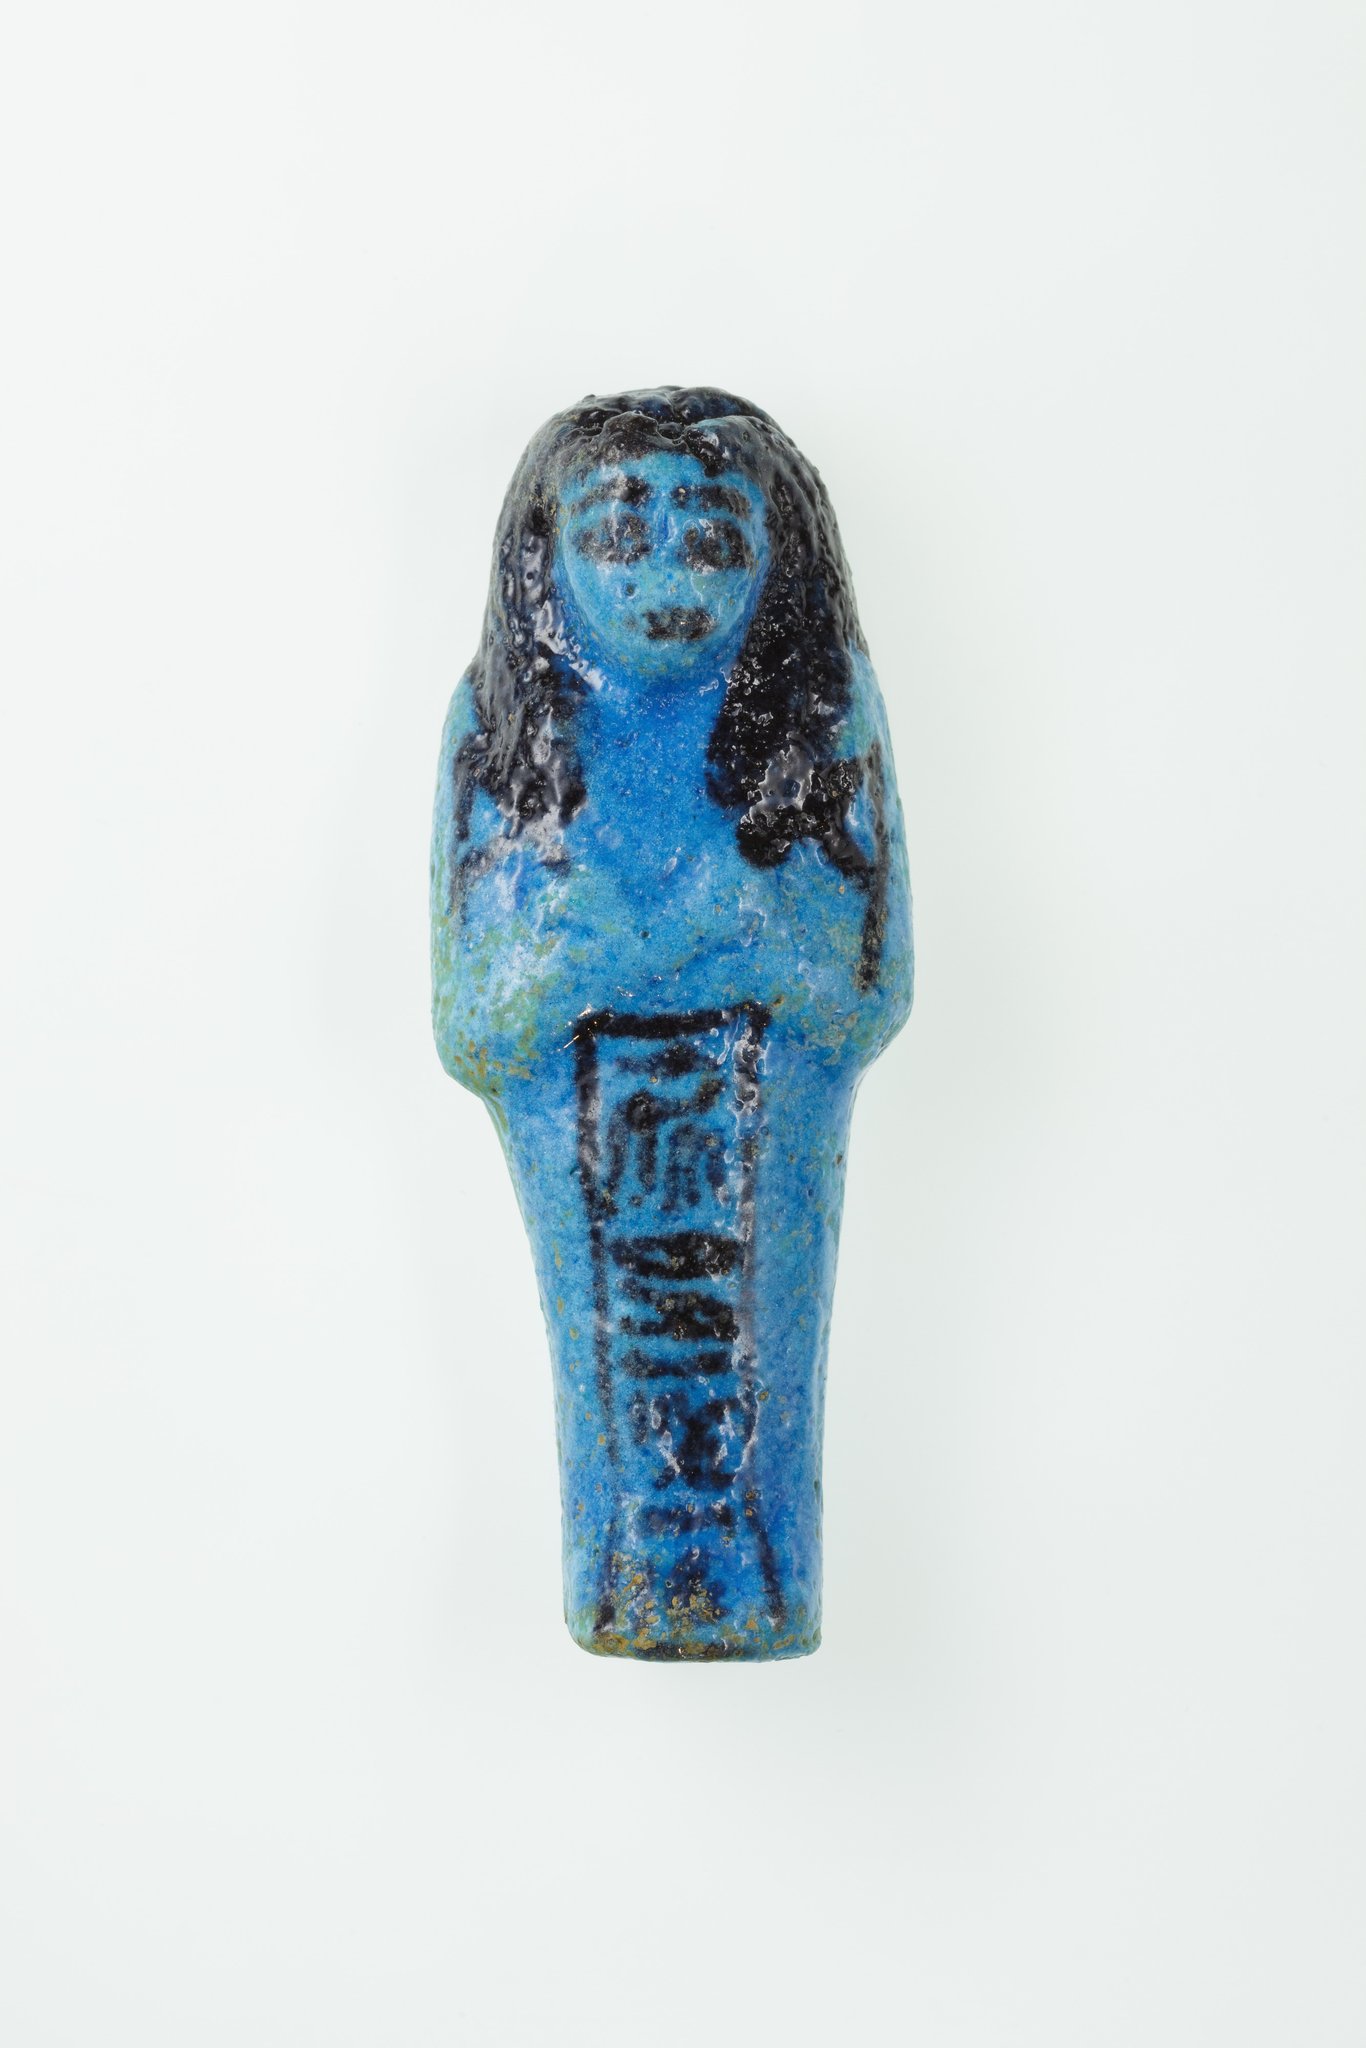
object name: shabti, worker, nauny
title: Worker Shabti of Nauny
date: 1050 BCE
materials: faience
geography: egypt